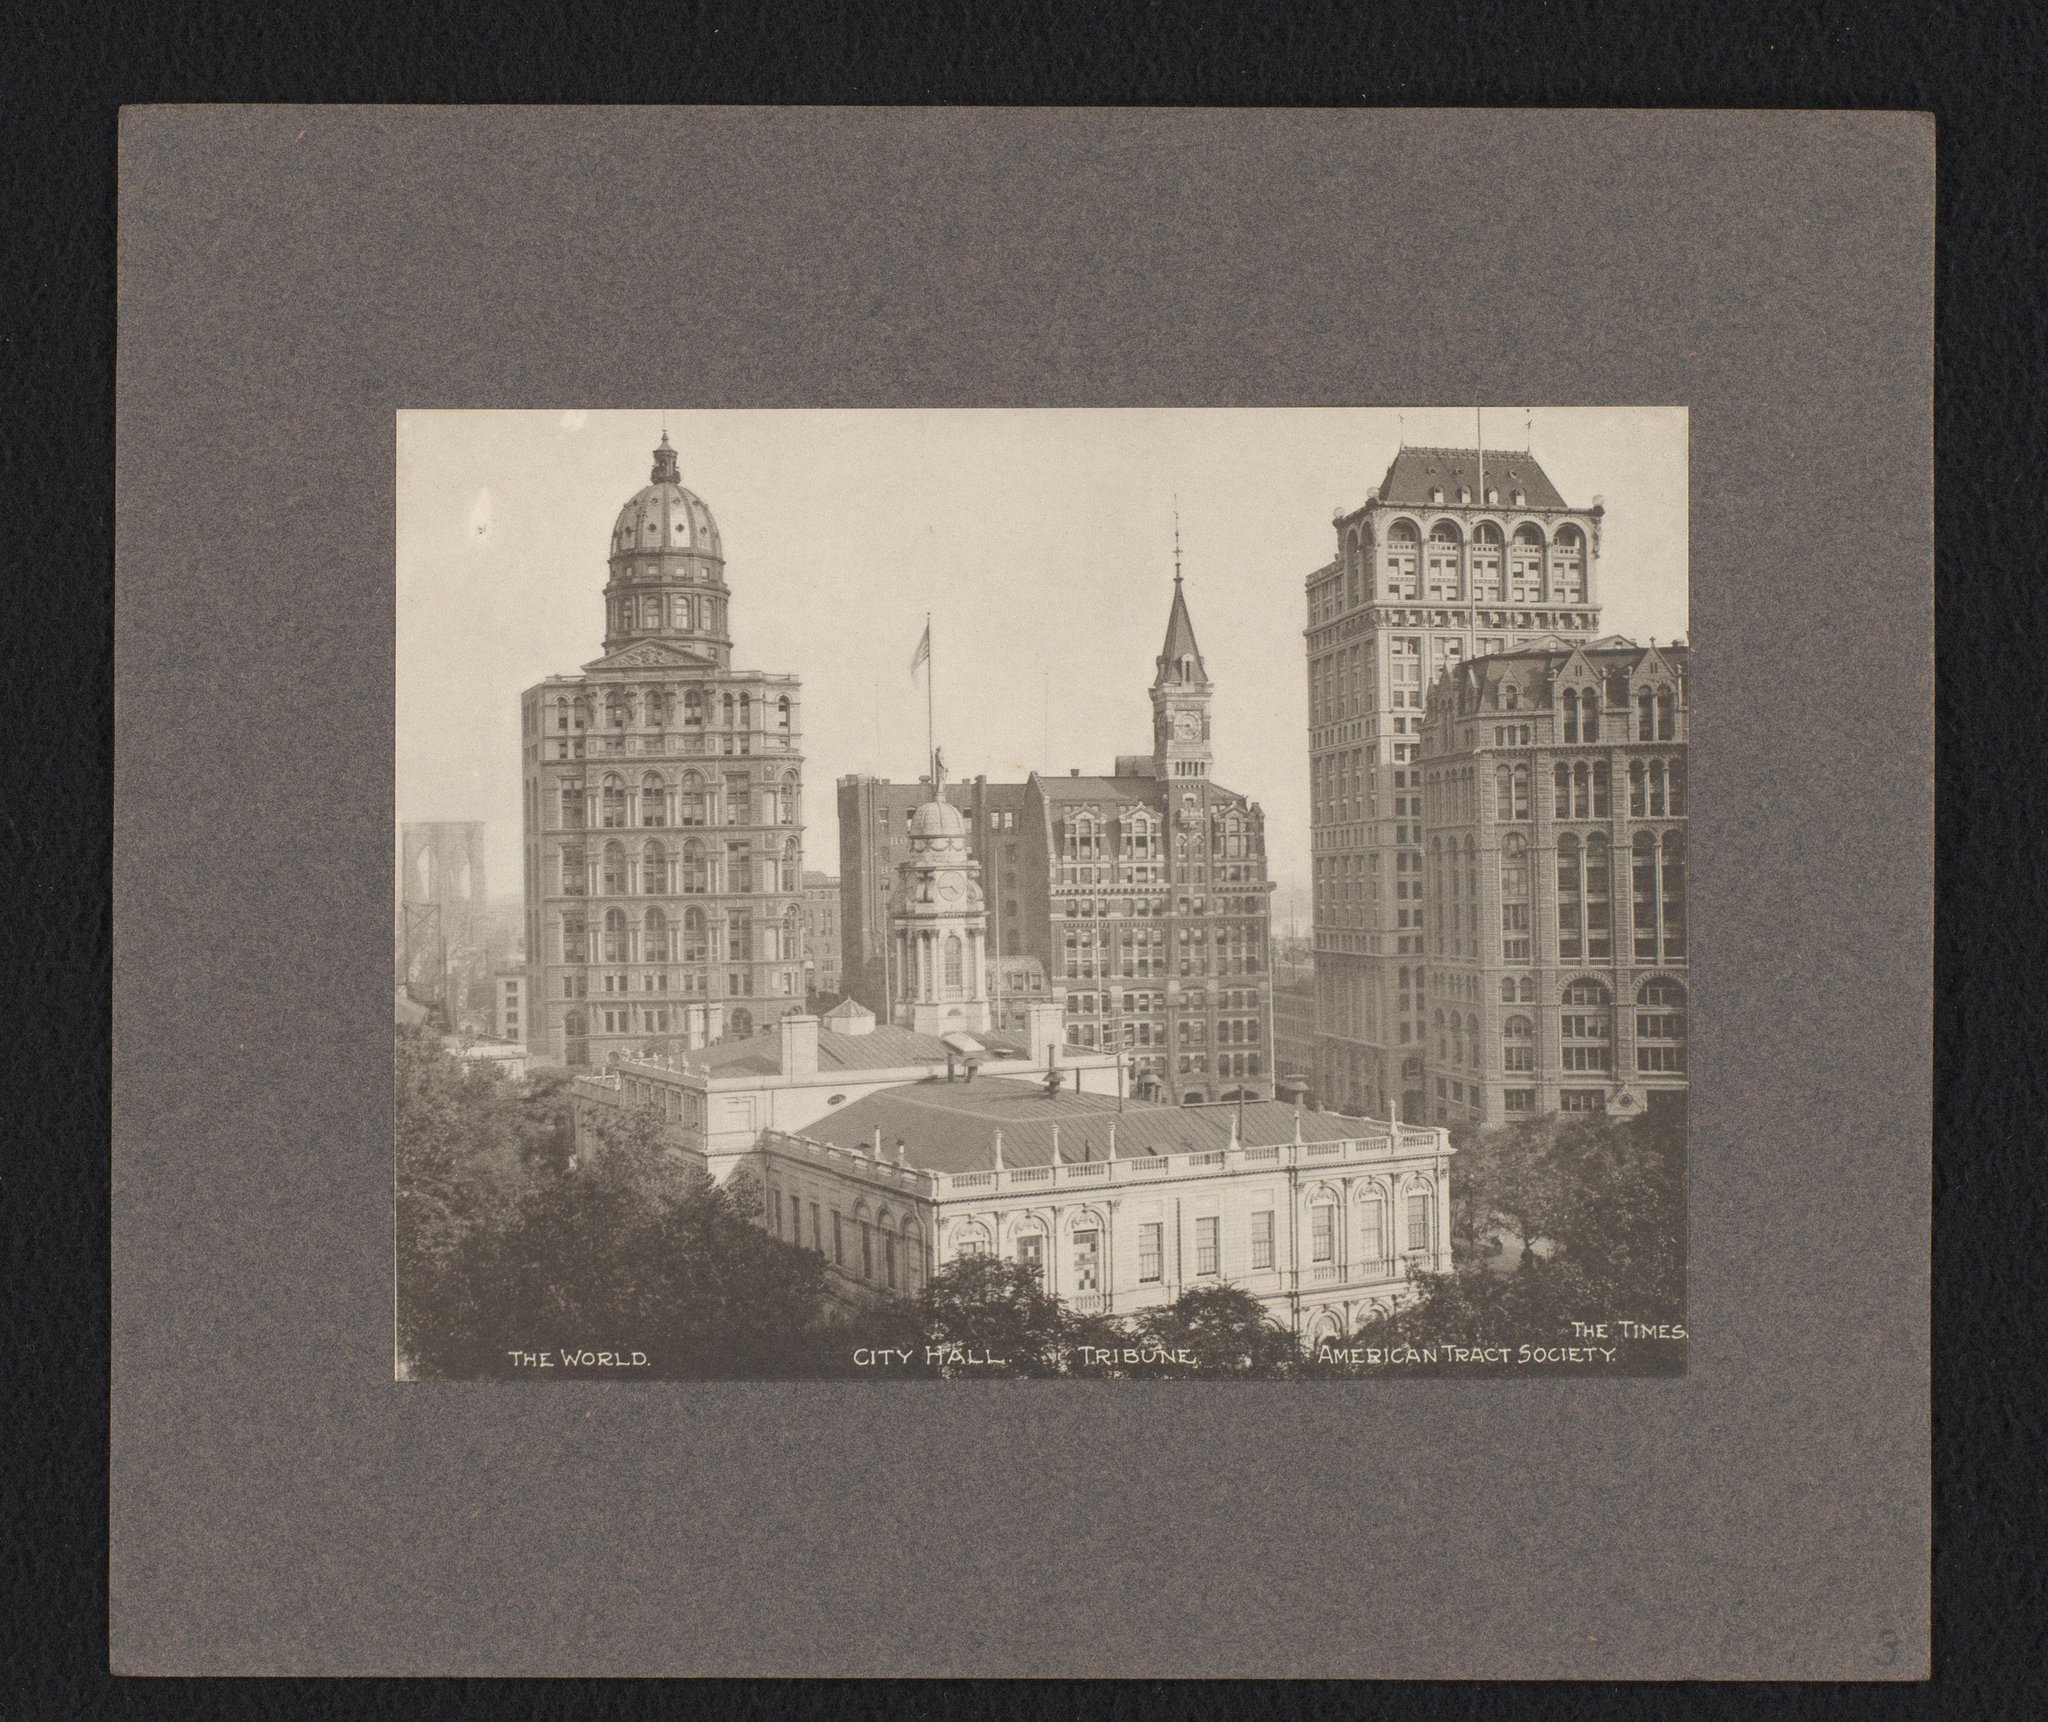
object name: album leaf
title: Gezicht op verschillende gebouwen in New York, waaronder het stadhuis, de Tribune, de Times en de American Tract Society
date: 1902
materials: paper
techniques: photograph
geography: new york city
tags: city-view in general; 'veduta', exterior ~ representation of a building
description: Deze prent maakt deel uit van een album.